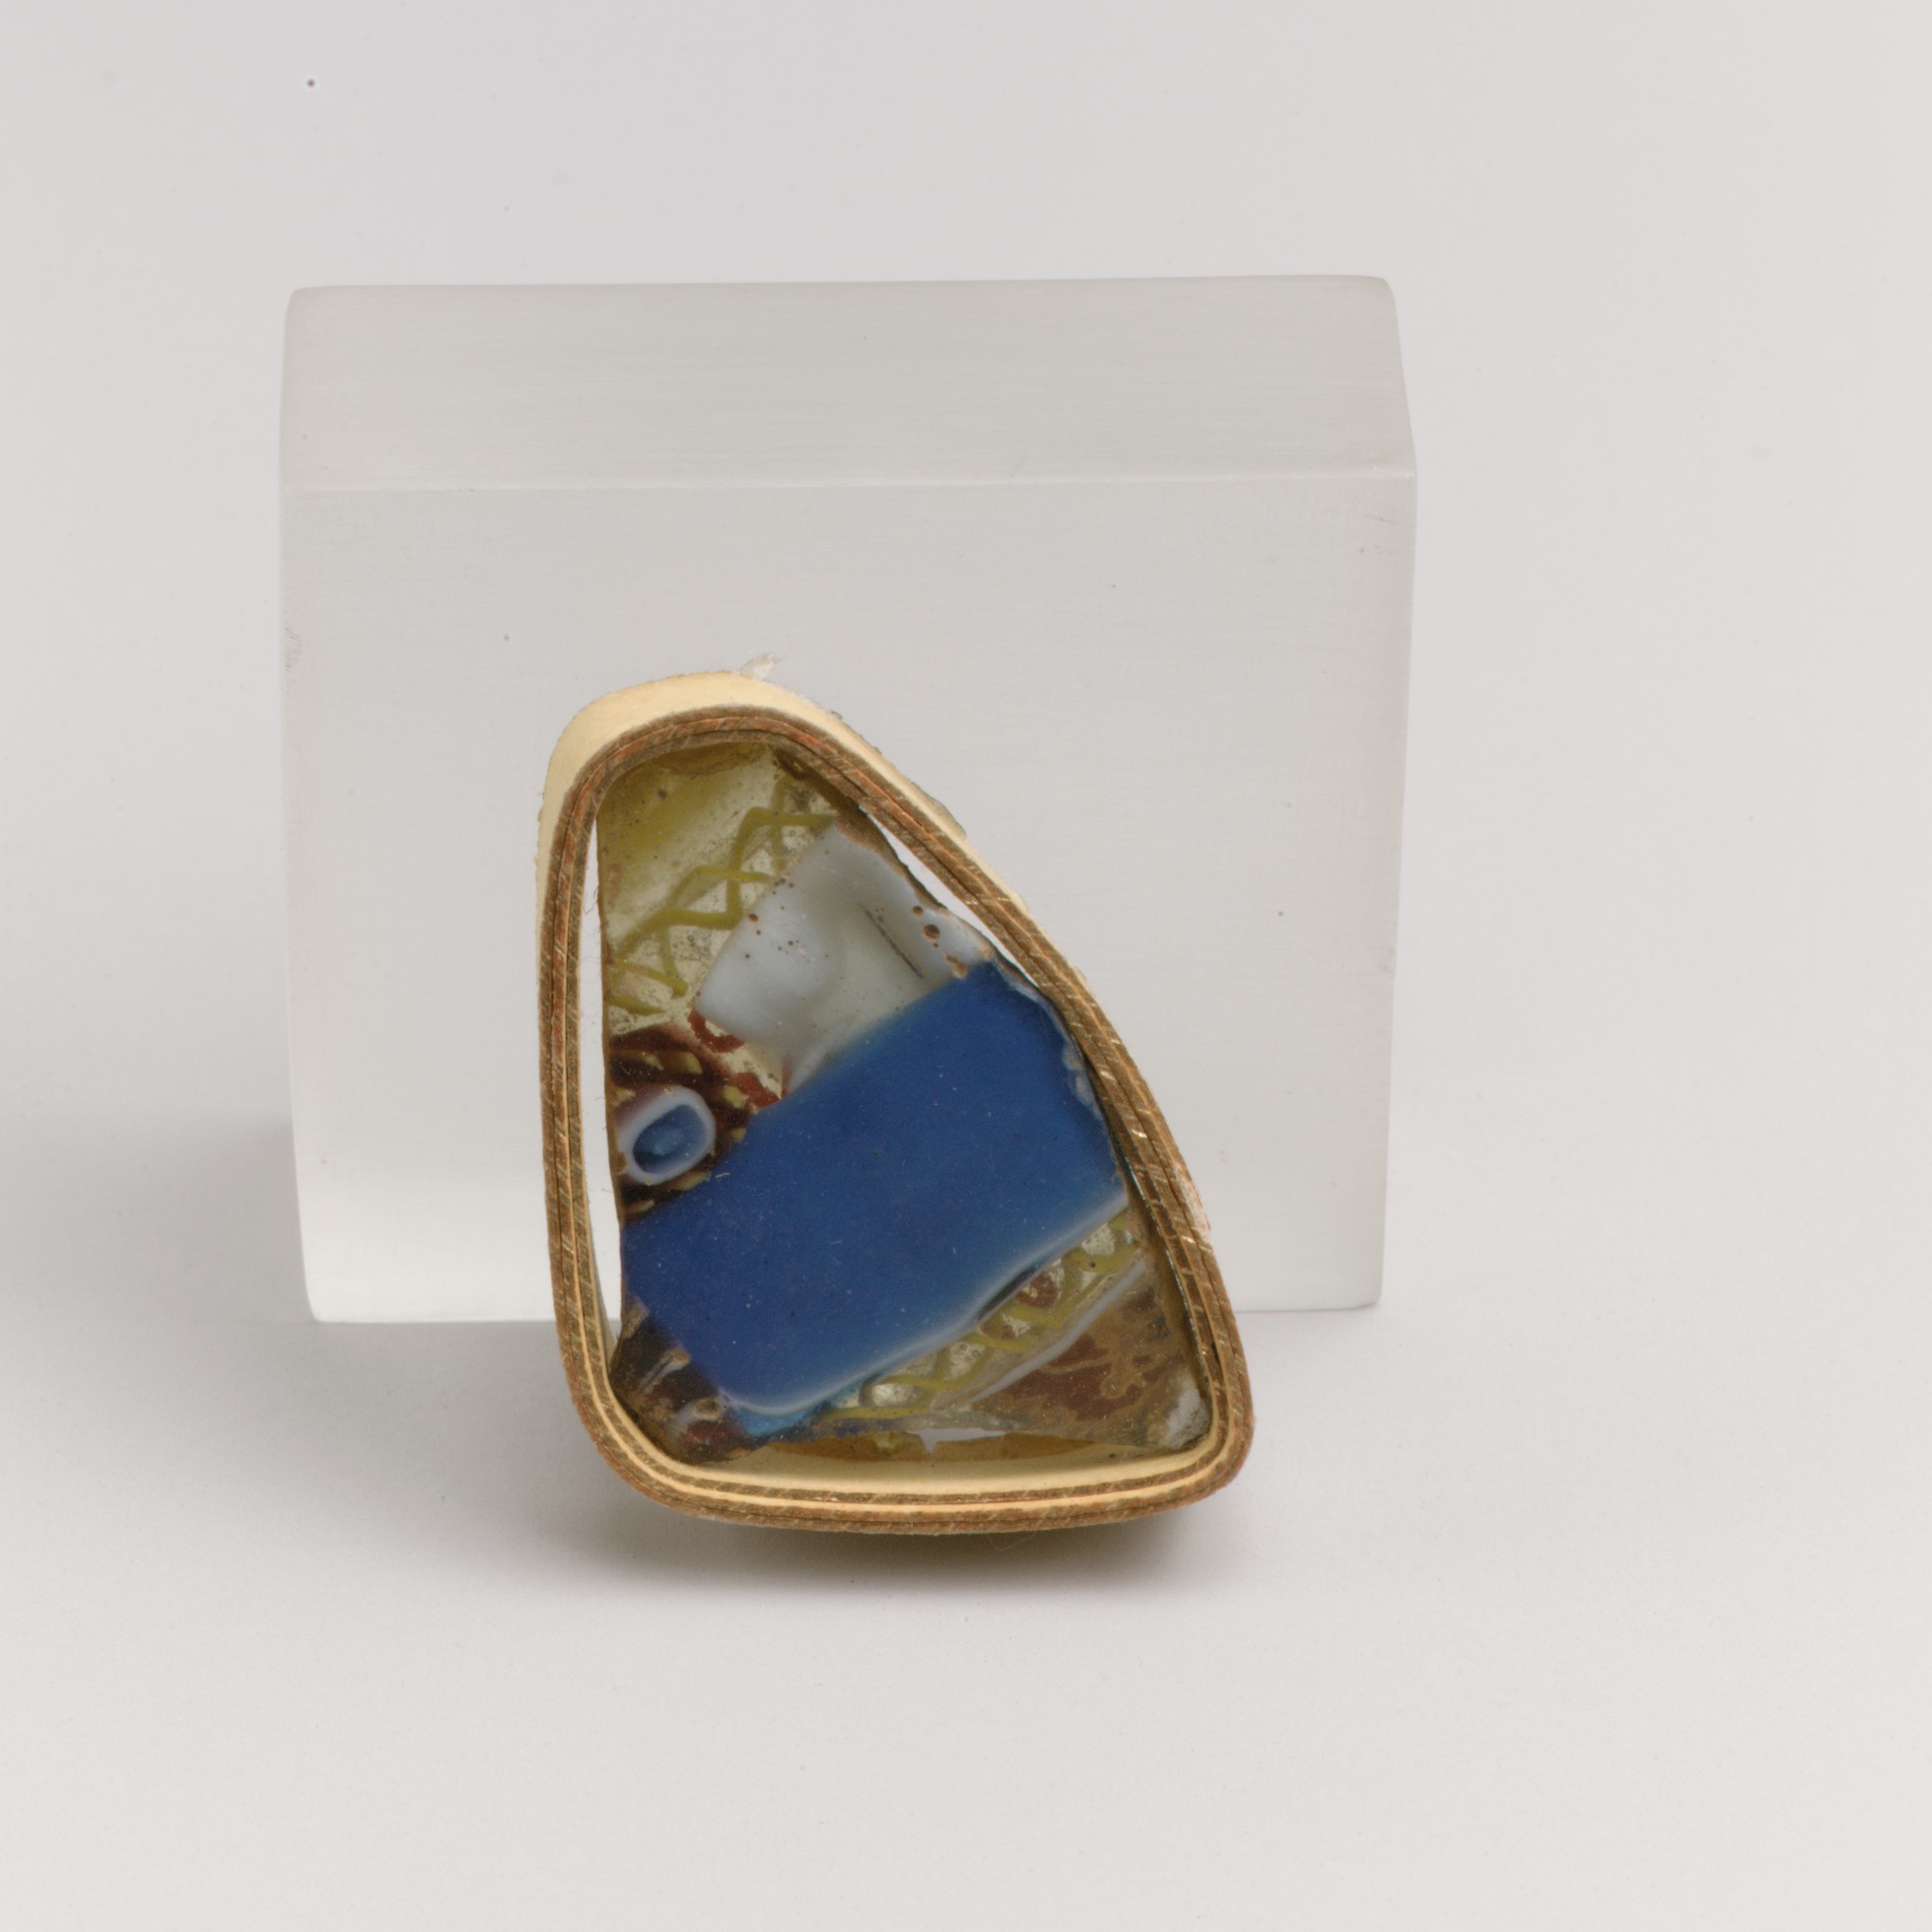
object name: fragment, mosaic bowl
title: Glass striped mosaic bowl fragment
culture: roman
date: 34 BCE-33 CE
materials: glass